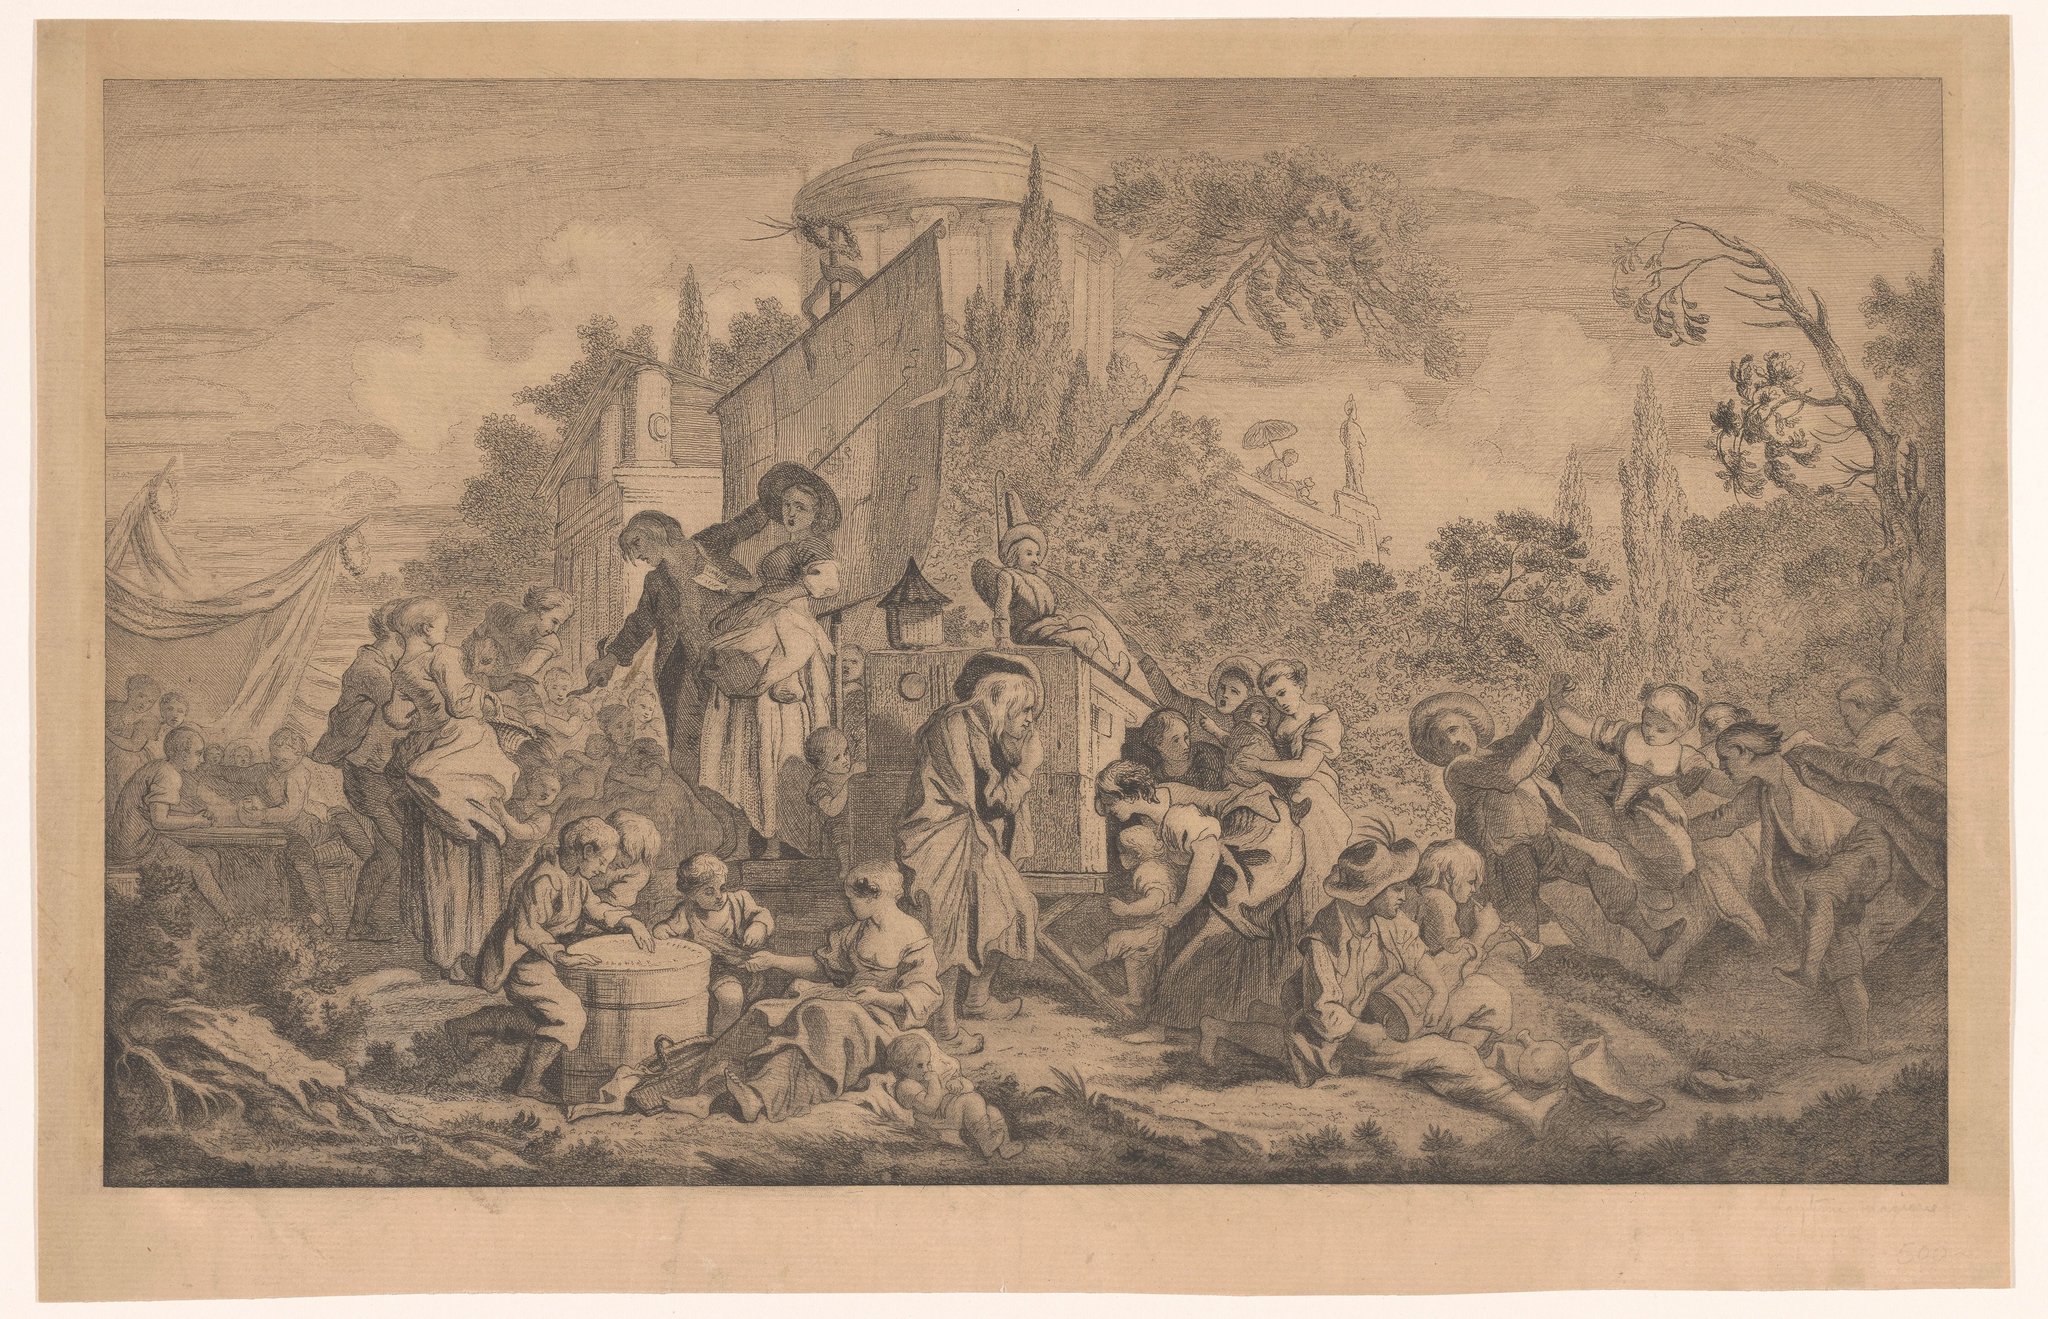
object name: print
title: Marktscène met een liedzanger en een kijkkast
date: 1800-1899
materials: paper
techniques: drypoint, etching, roulette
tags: hurdy-gurdy - cc - out of doors, folk dancing (men and women together), performance in the open air (pleasure fair), pleasure fair and circus, peep-show, ballad singer, ballad seller - cc - out of doors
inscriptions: collector's mark: Lugt 4780, collector's mark: Lugt 2228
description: In het midden hebben zich mensen verzameld rond een kijkkast met bovenop een harlekijn. Links daarvan staat een liedzanger die met een aanwijsstok wijst naar prenten die op een rol tussen stokken zijn geplakt. Naast hem staat een vrouw, waarschijnlijk verkoopt zij liederen. Rechts dansen mensen op de muziek van een draailier en een trompet.